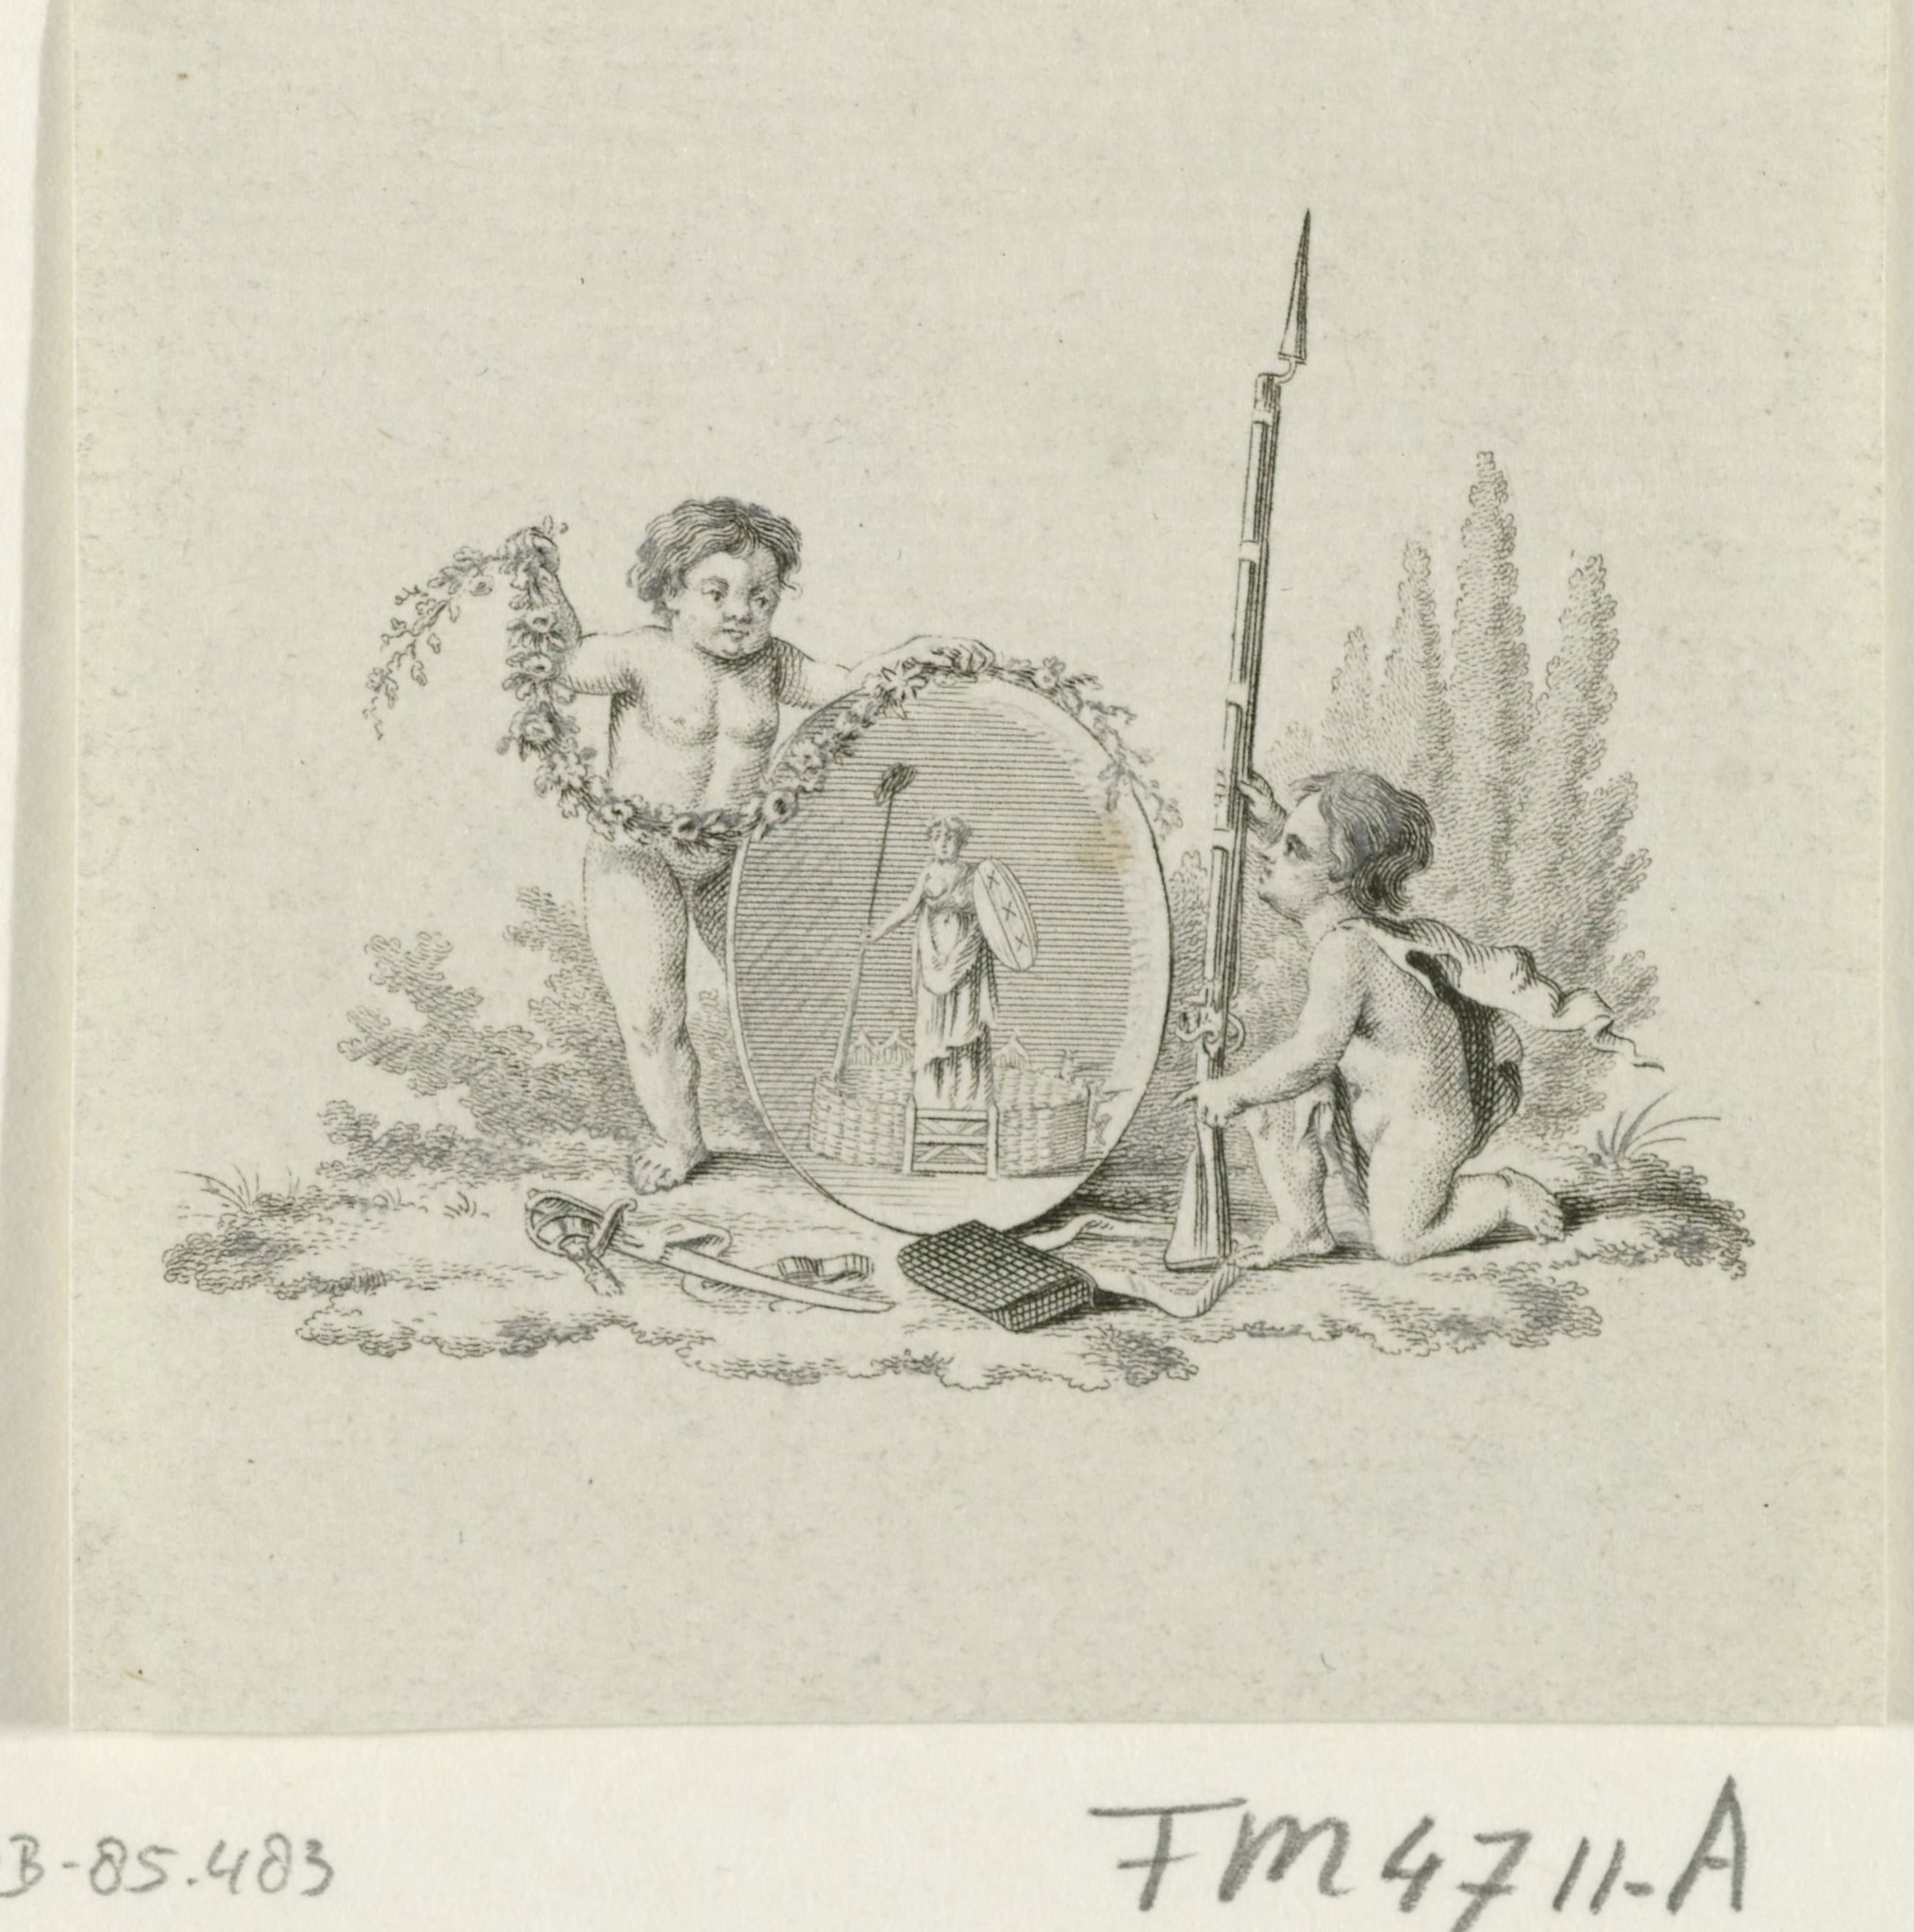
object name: print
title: Vignet met het embleem van het exercitiegenootschap Tot Nut der Schuttery, 1786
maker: Anonymous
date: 1786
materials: paper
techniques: engraving, etching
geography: northern netherlands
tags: amsterdam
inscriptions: collector's mark: Lugt 2228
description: Allegorisch vignet met twee putti met het embleem van het Amsterdamse exercitiegenootschap Tot Nut der Schuttery, 1786.